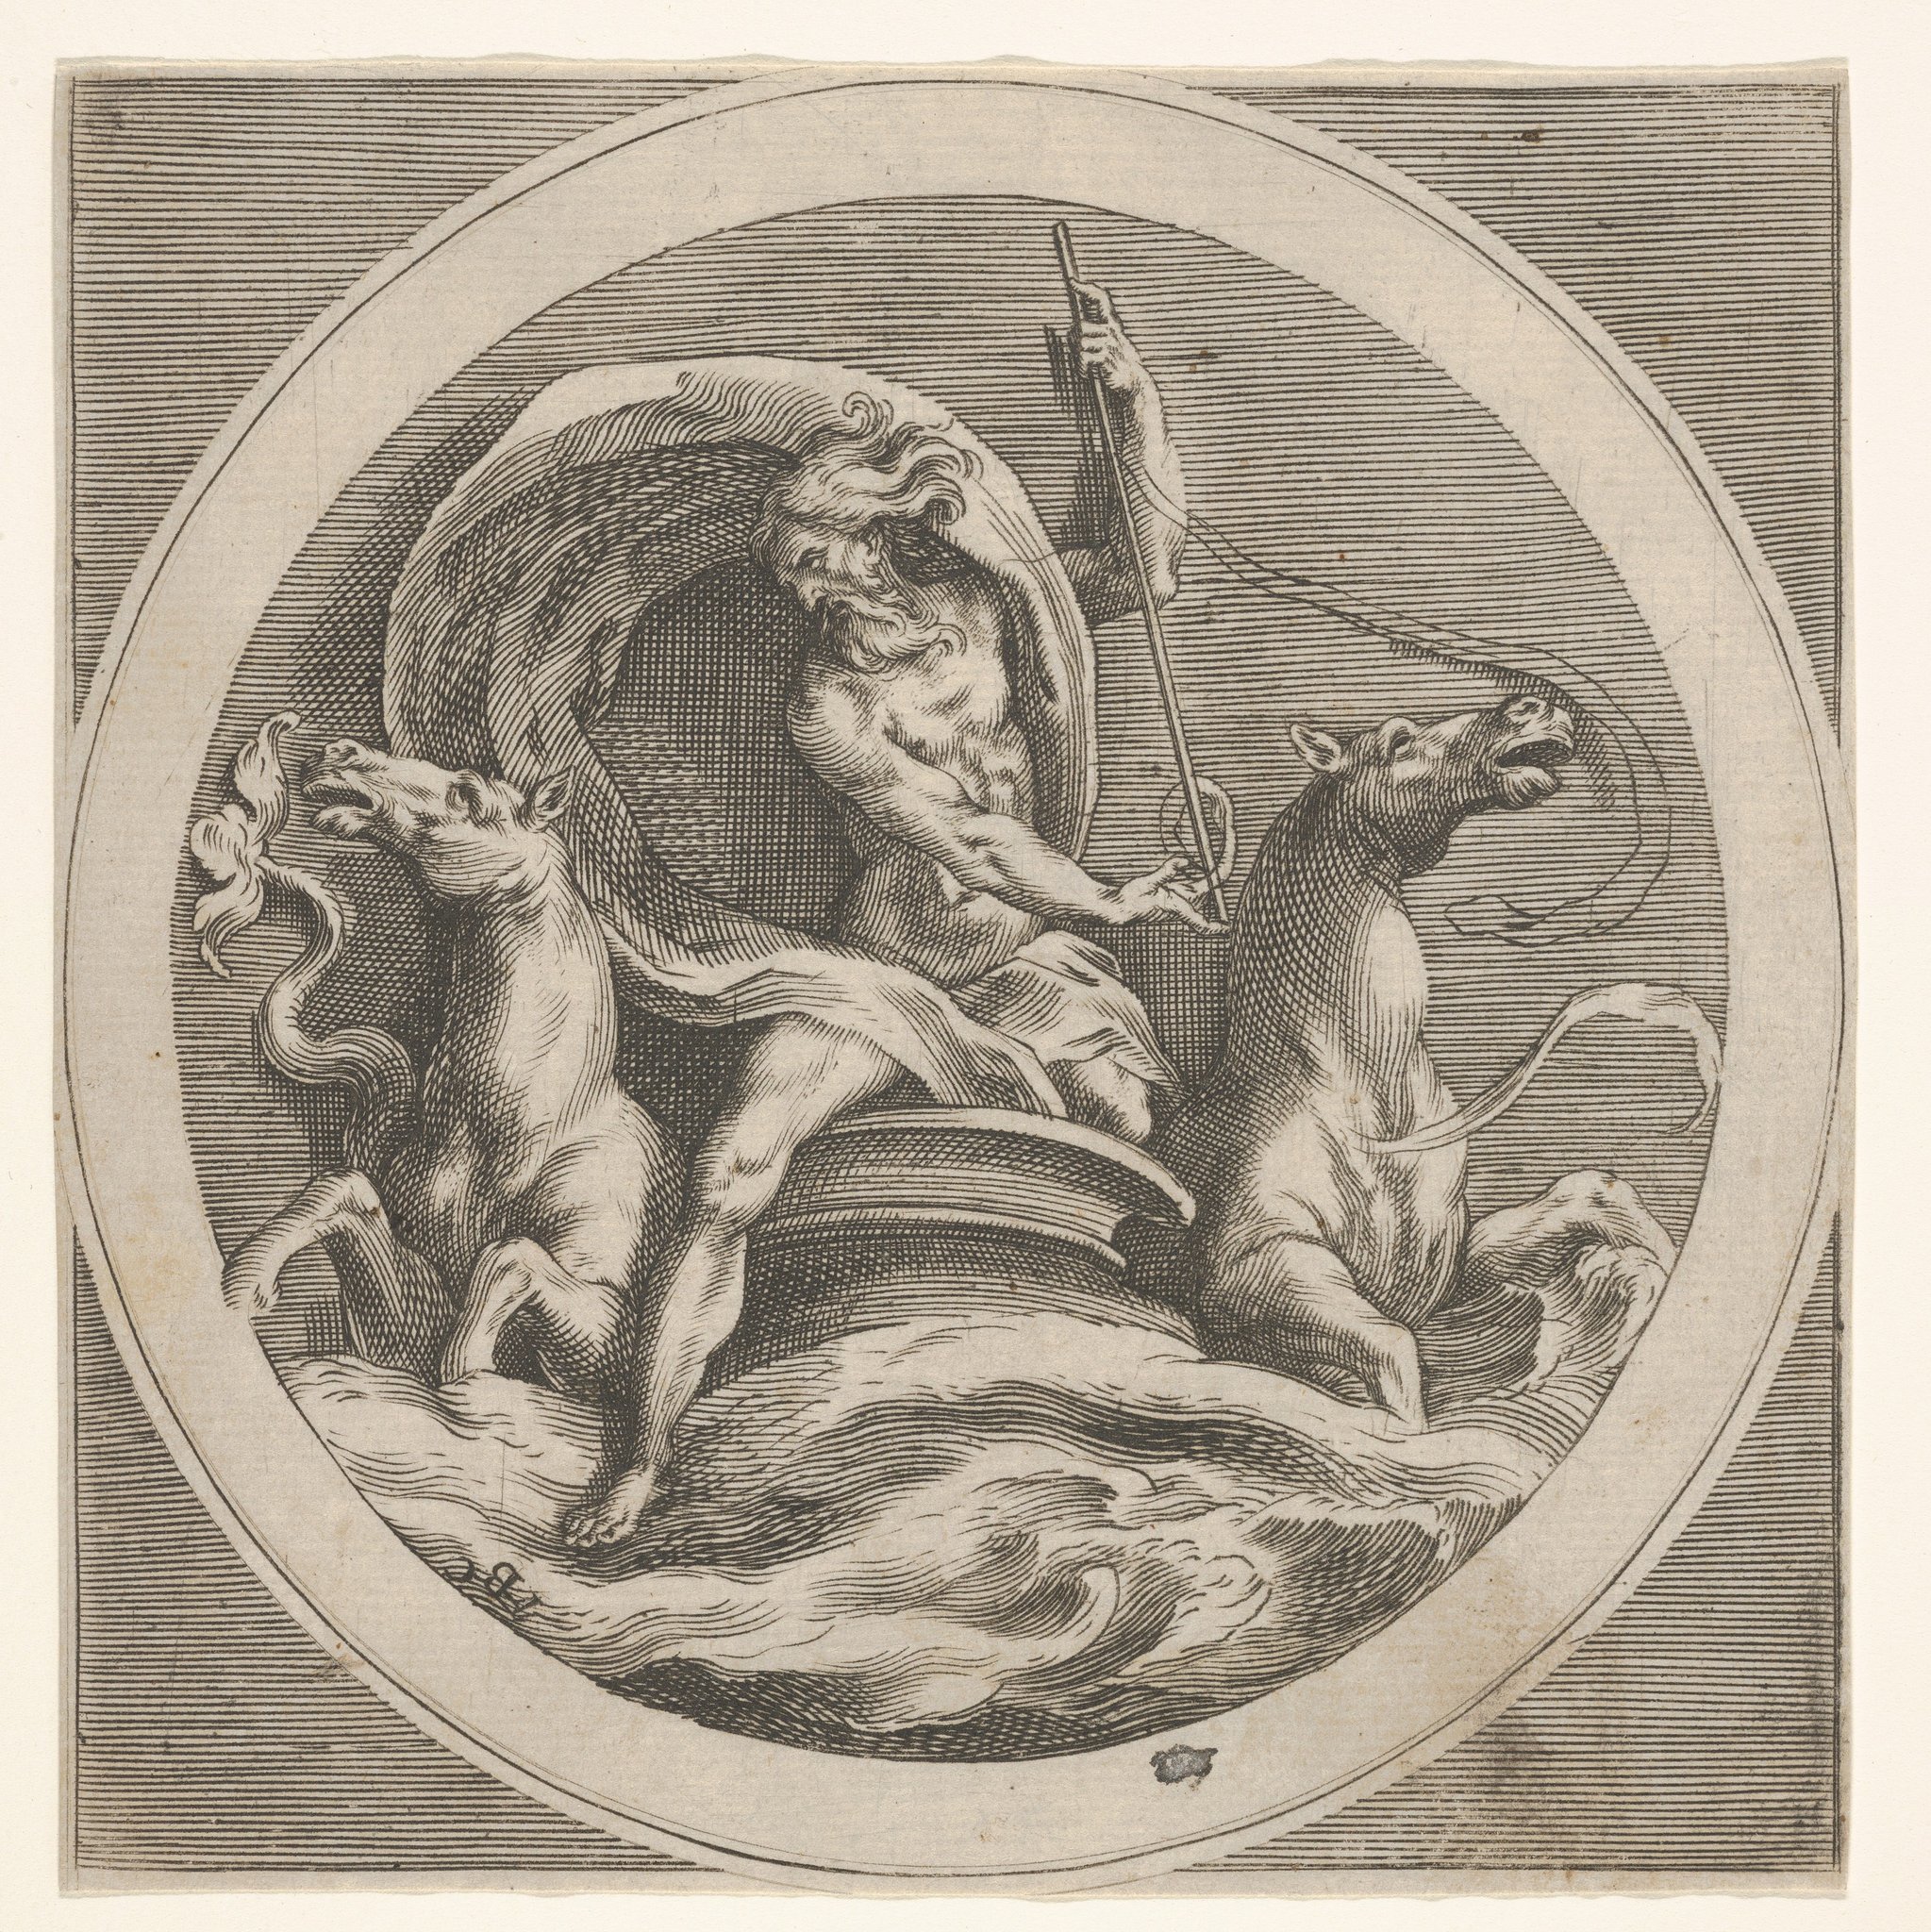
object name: print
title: Neptune rising from the sea and bearing a staff, accompanied by two horse-headed sea creatures, reverse copy after a series of engravings by Cherubino Alberti of mythological scenes after Polidoro da Caravaggio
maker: Anonymous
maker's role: artist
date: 1550-1600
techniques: engraving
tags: mythical creatures,neptune,horses